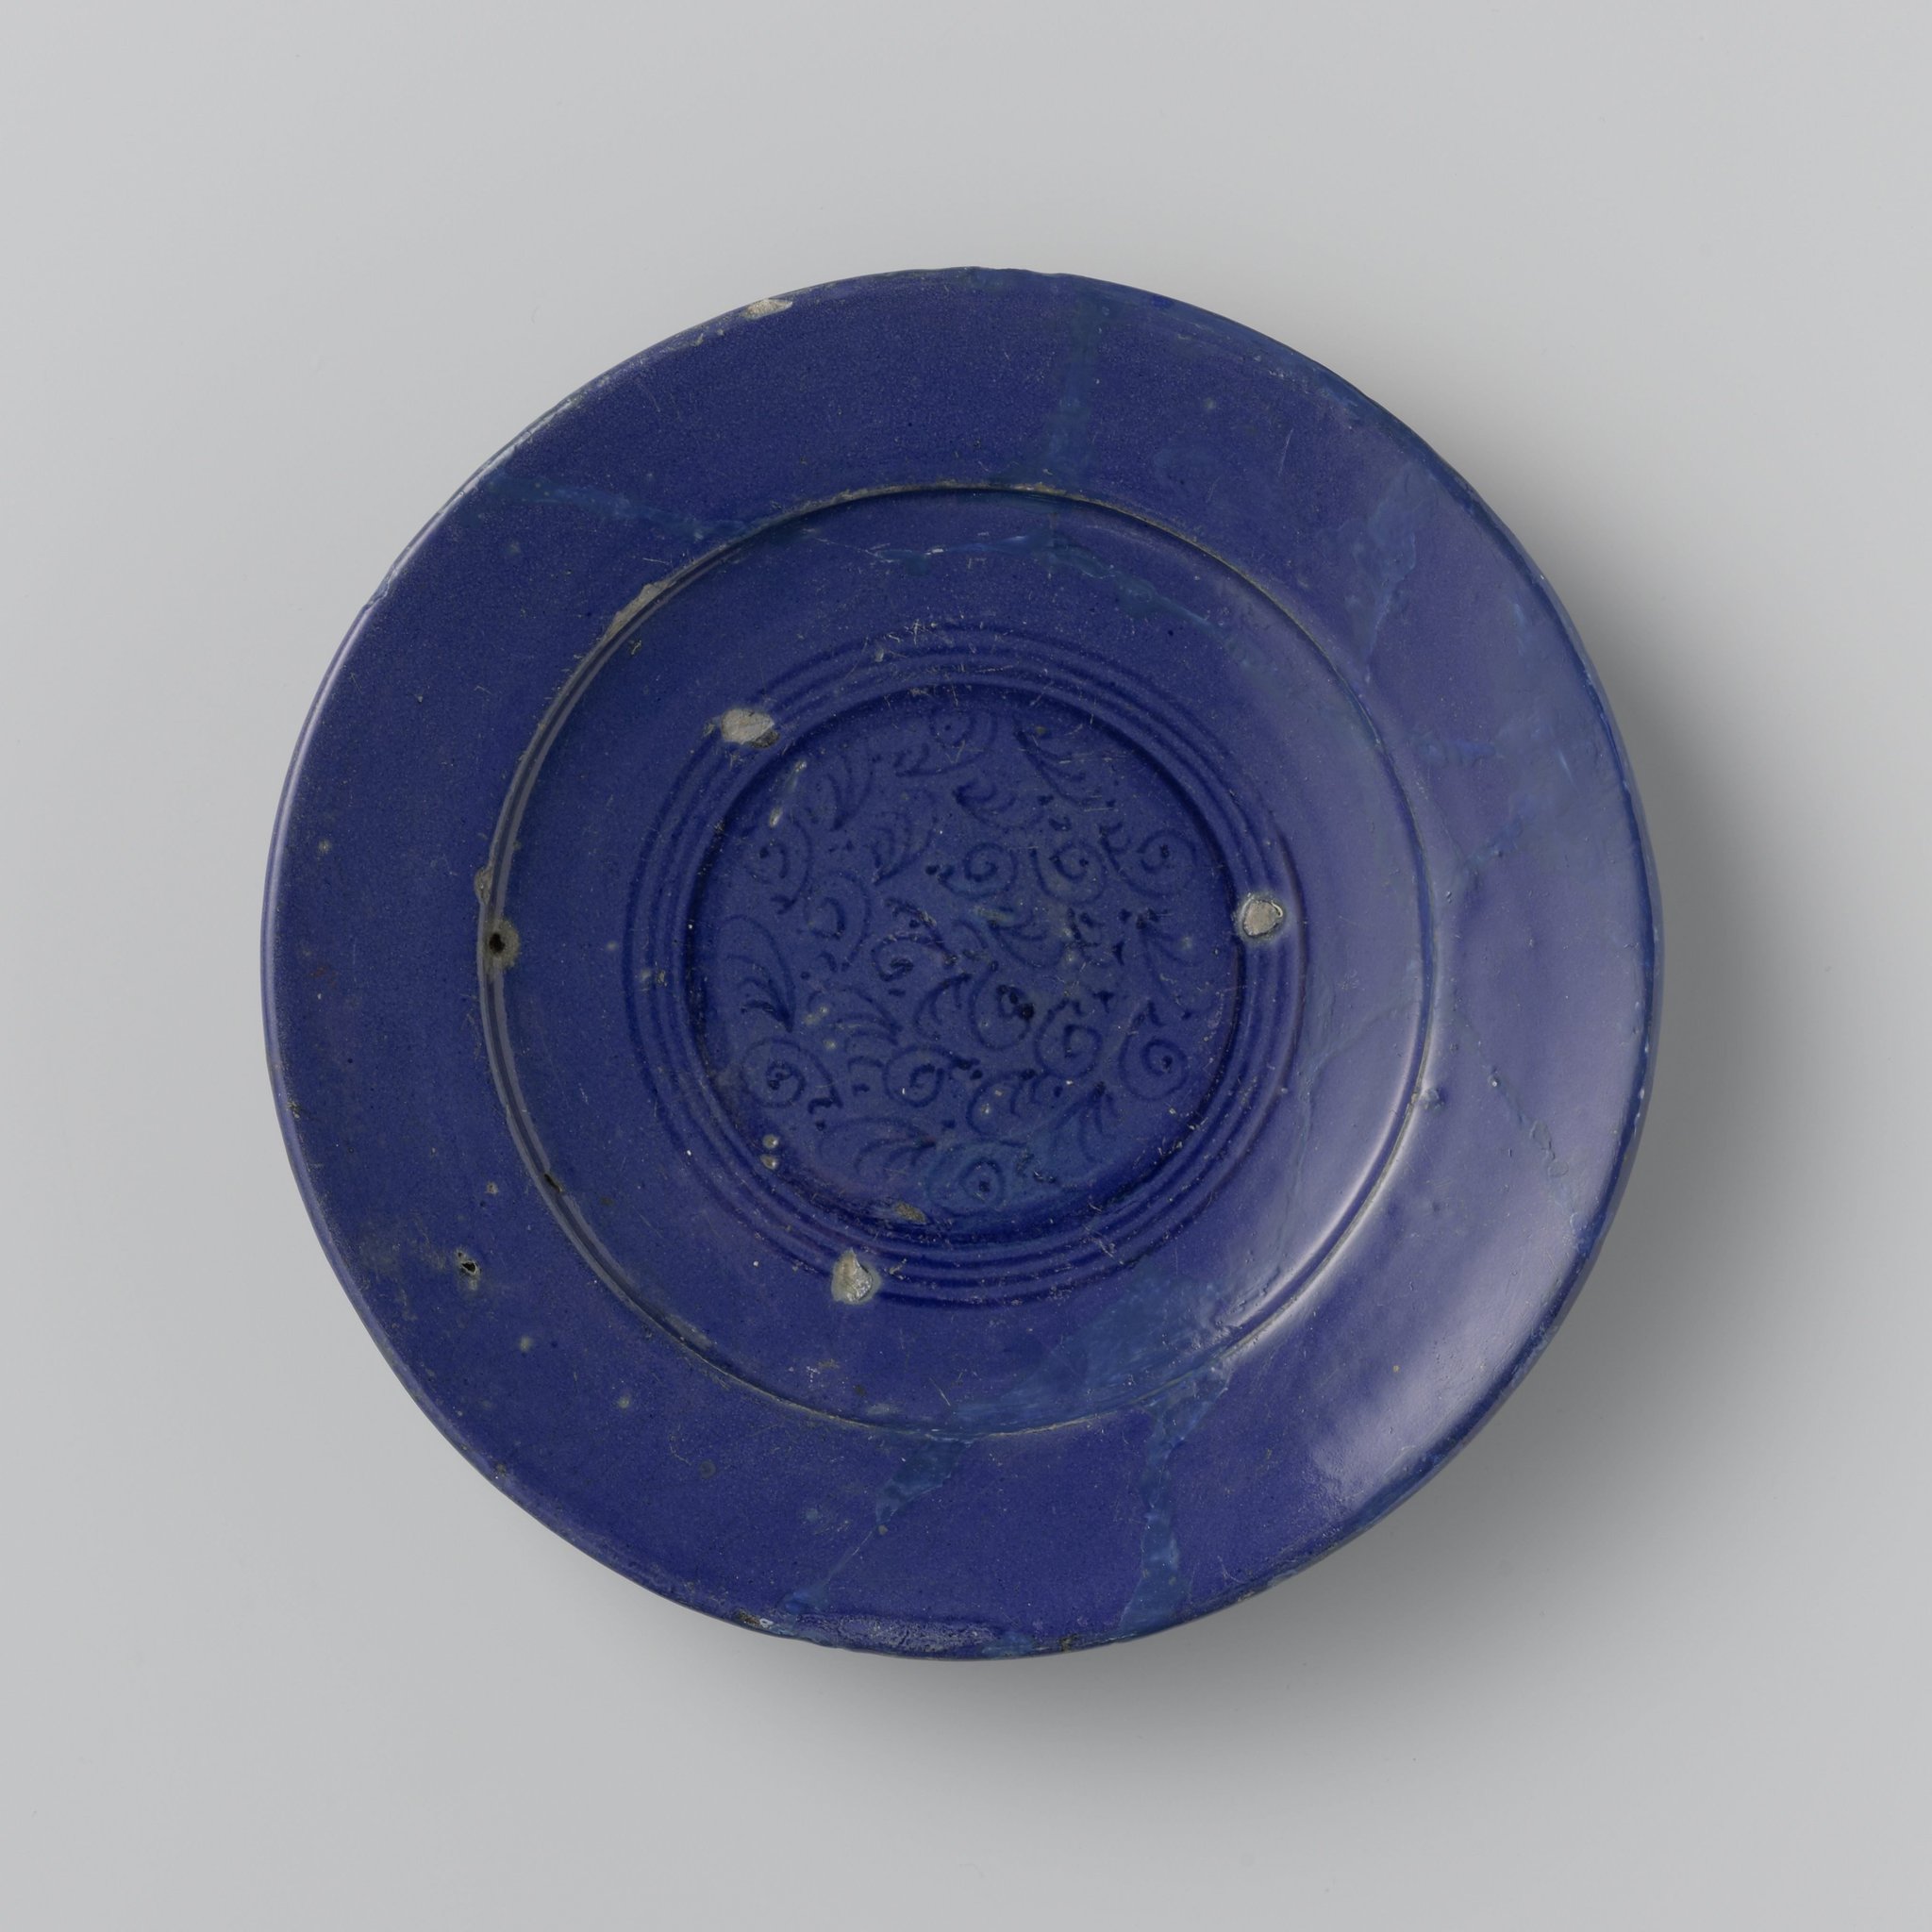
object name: plate dish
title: Bord, beschilderd met ranken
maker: Anonymous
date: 1620-1640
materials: earthenware, glaze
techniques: maiolica, painted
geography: delft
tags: delft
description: Rond bord van blauw beschilderde majolica. Het bord heeft een blauwe fond en is beschilderd met blauwe ranken. Het bord is een bodemvondst uit Delft.